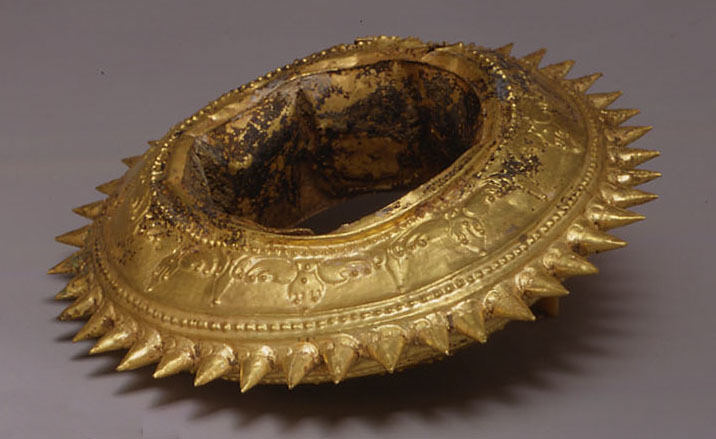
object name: bracelet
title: Spiked Bracelet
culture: indonesian, javanese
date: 701-933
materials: gold